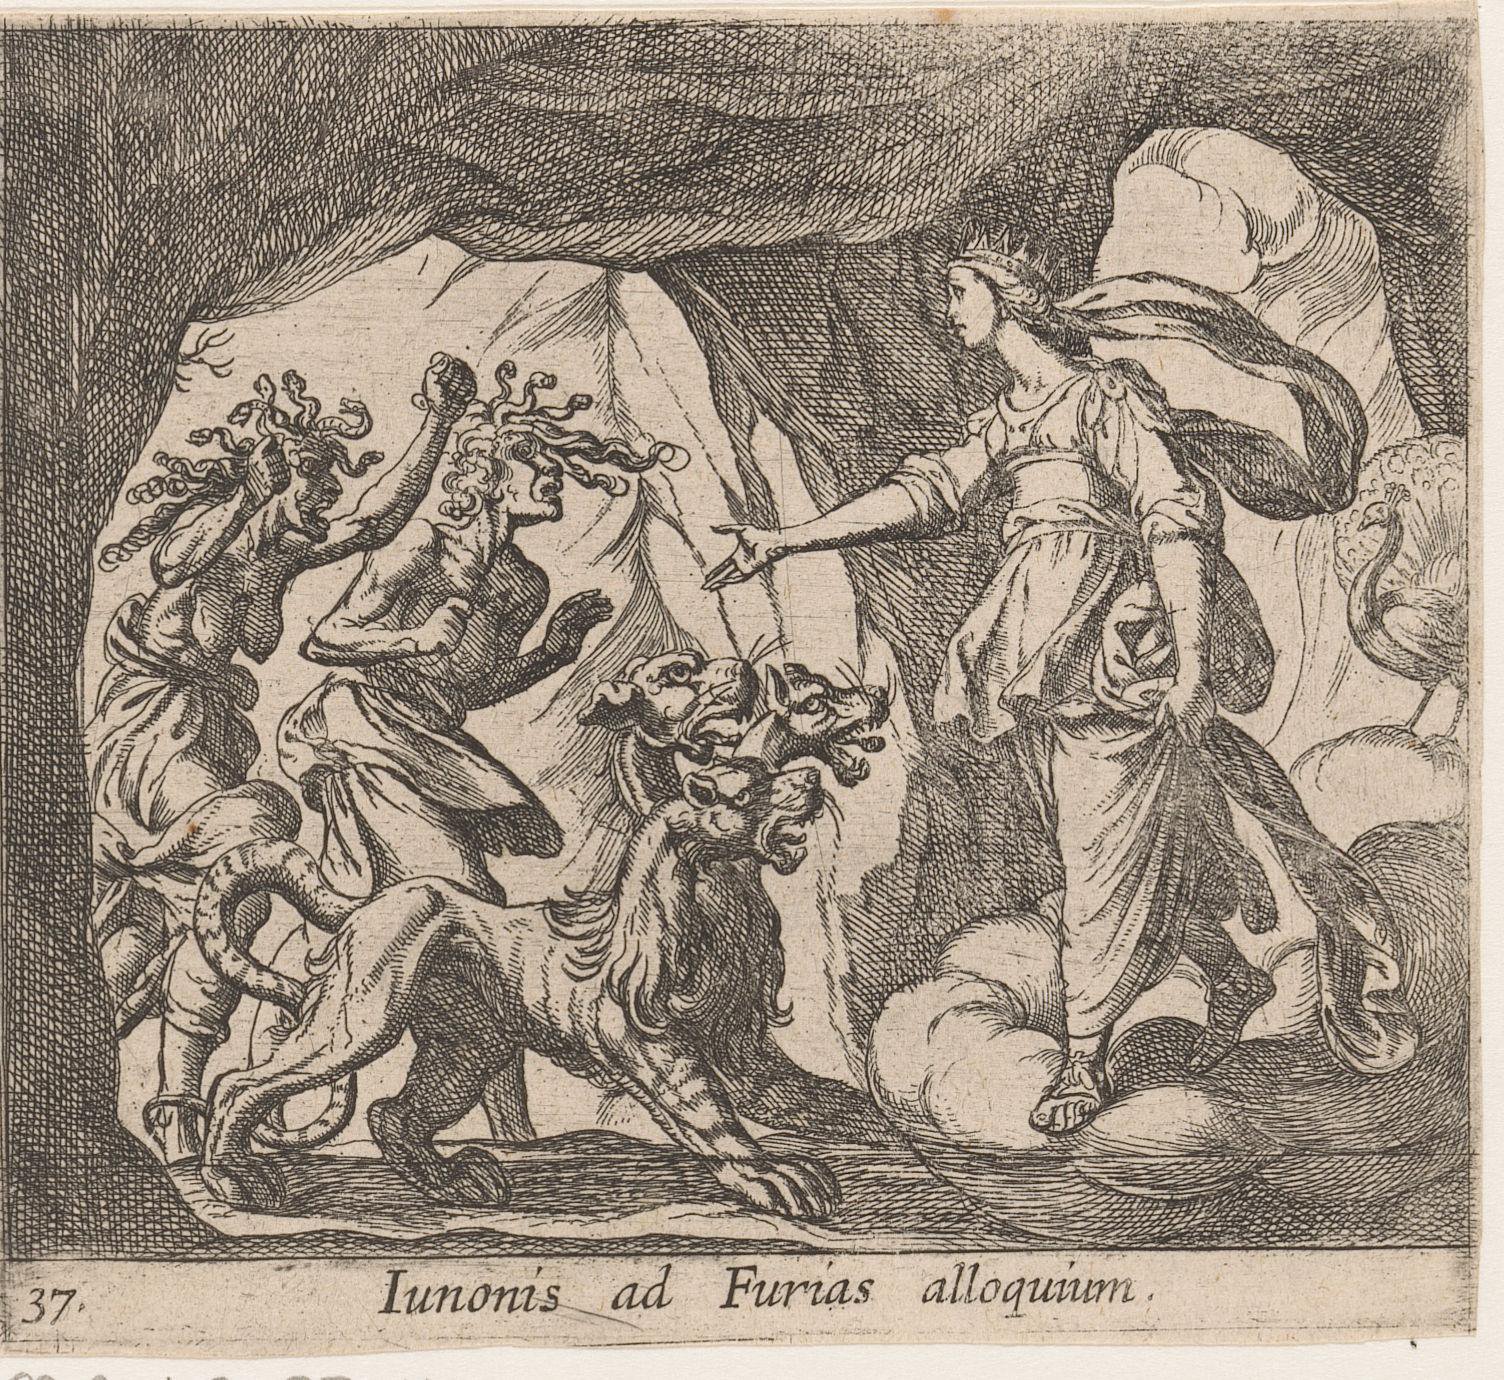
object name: print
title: Juno en de Furiën bij de poort van de Hades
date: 1606-1638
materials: paper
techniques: etching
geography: italy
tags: juno descends into hades to ask the furies to drive athamas mad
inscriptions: collector's mark: ‘Hinloopen’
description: Juno staat met haar pauw voor de poort van de Hades en vraagt de Furiën om Athamas gek te maken. Titel in het Latijn in ondermarge.